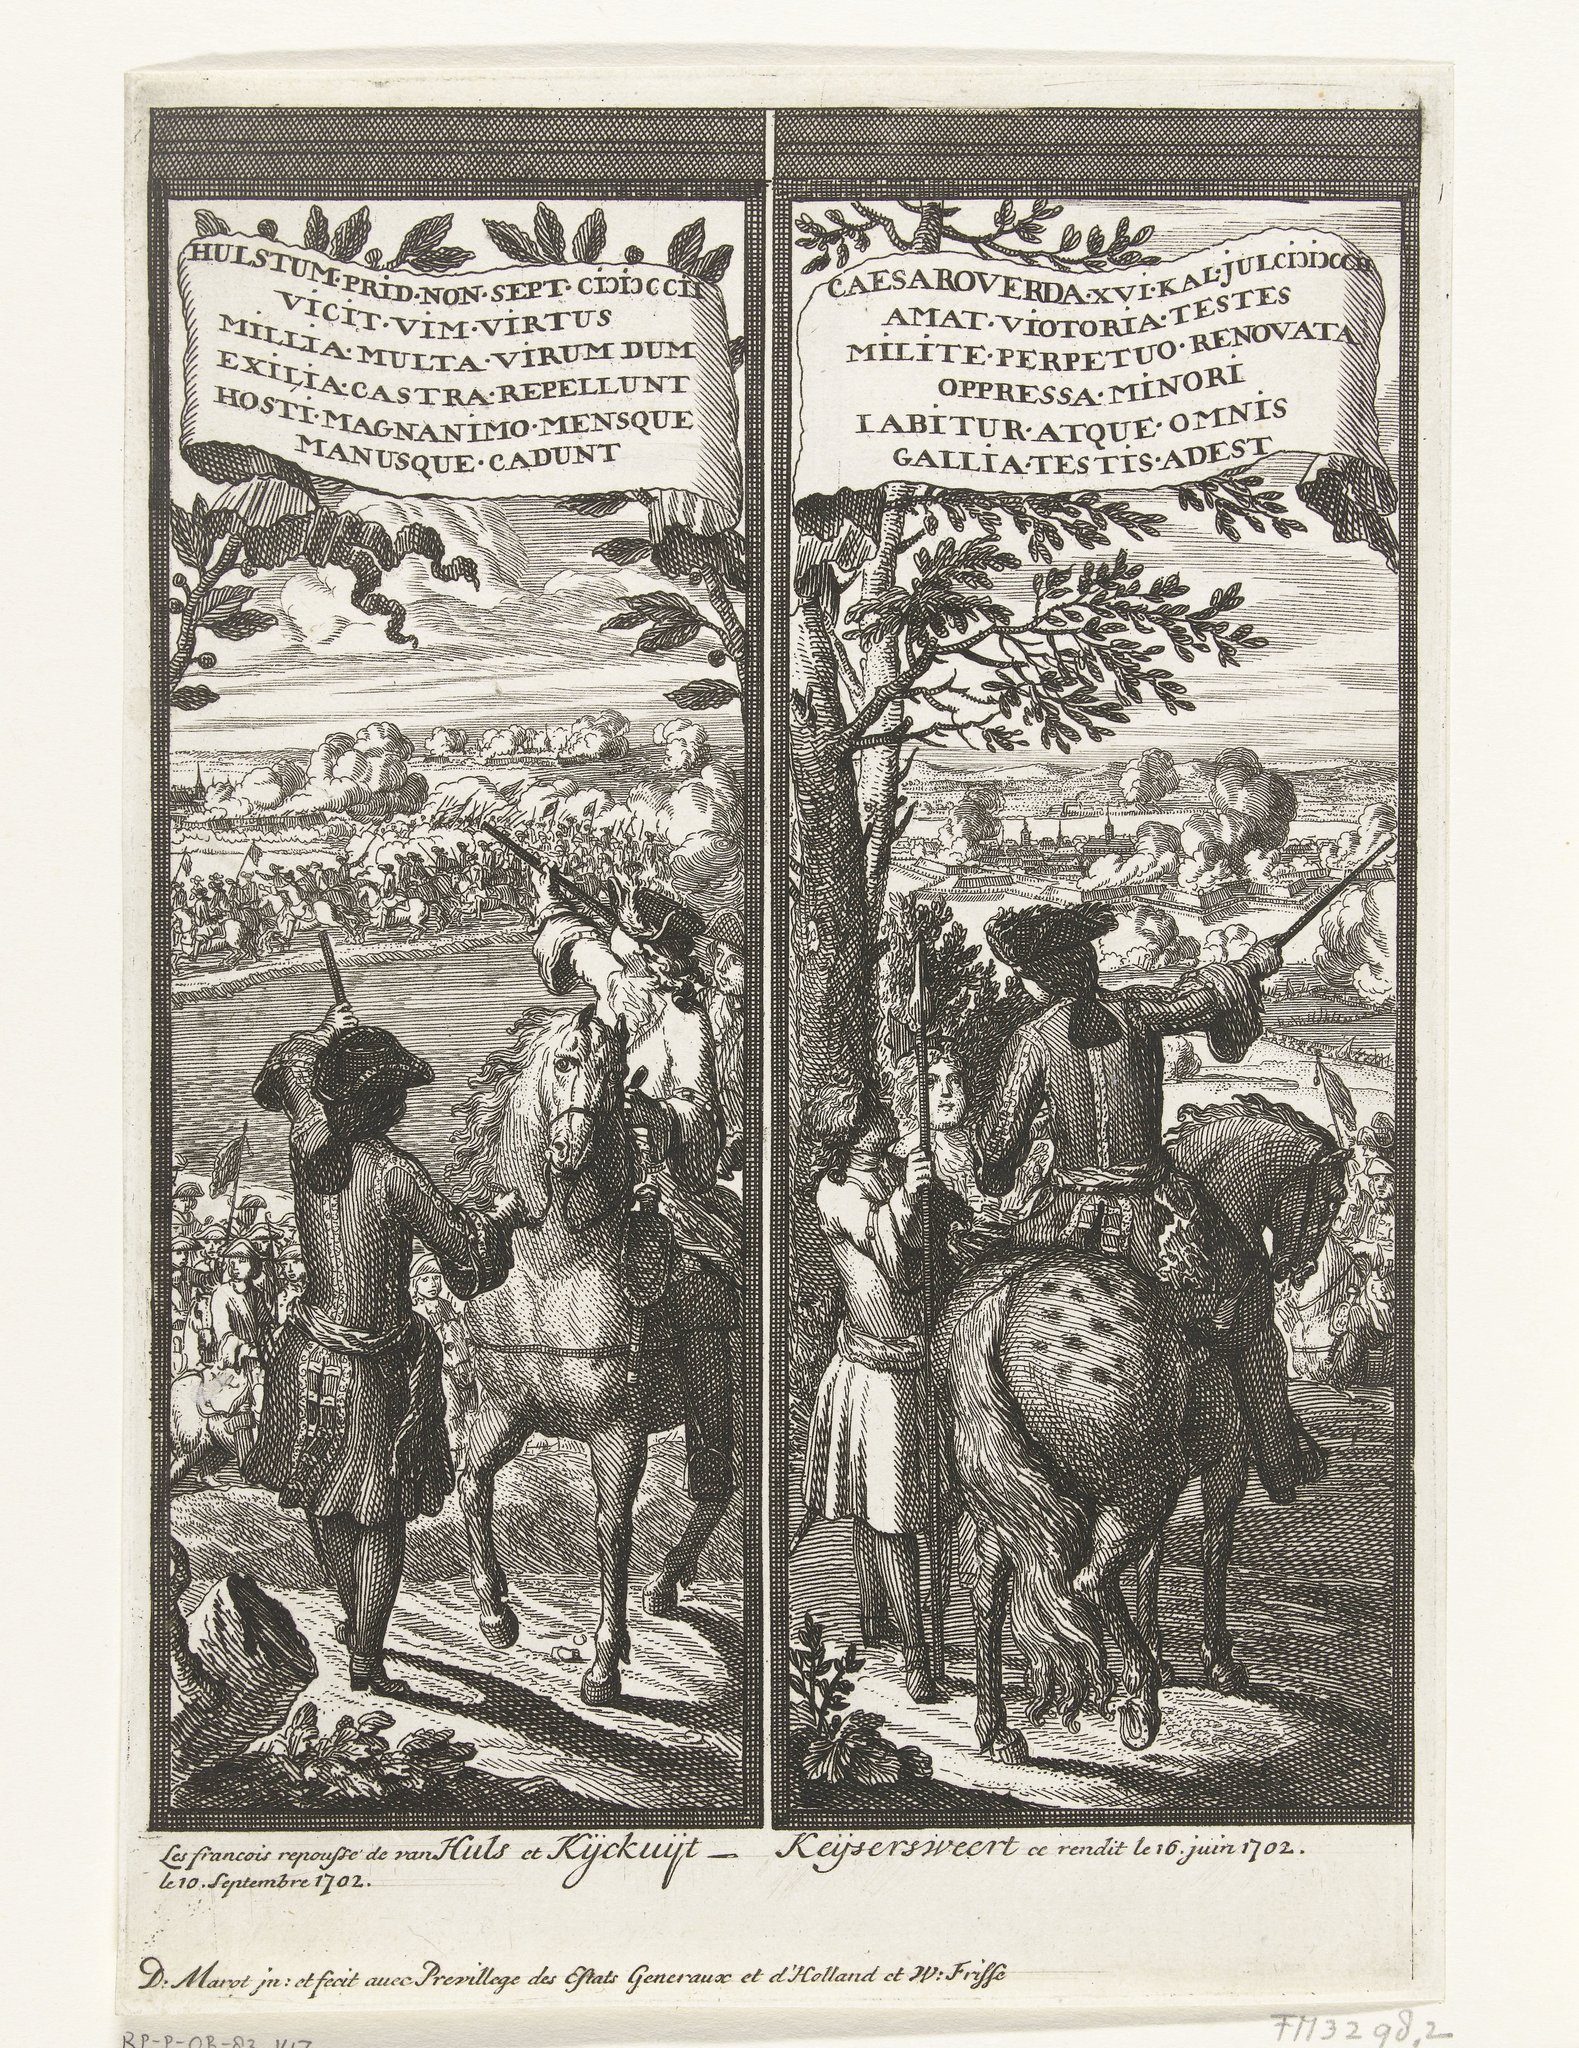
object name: print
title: Les francois repoussé de van Huls et Kyckuyt - le 10. Septembre 1702 / Keysersweert ce rendit le 16. juin 1702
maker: daniël marot (i)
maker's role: draughtsman, print maker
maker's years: 1661-1752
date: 1702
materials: paper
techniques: etching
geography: northern netherlands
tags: capture of city (after the siege)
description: Paneel met twee voorstellingen van de overwinningen te Hulst en Kijkuit op 10 september en te Keizersweerd op 17 juni 1702. Onderdeel van de decoraties op de stellage met de Tempel van Mars tijdens het vuurwerk op de Hofvijver op 13 december 1702 te Den Haag. De Tempel van Mars was versierd met acht panelen met voorstellingen van overwinningen van de geallieerden op Frankrijk en Spanje in het jaar 1702.